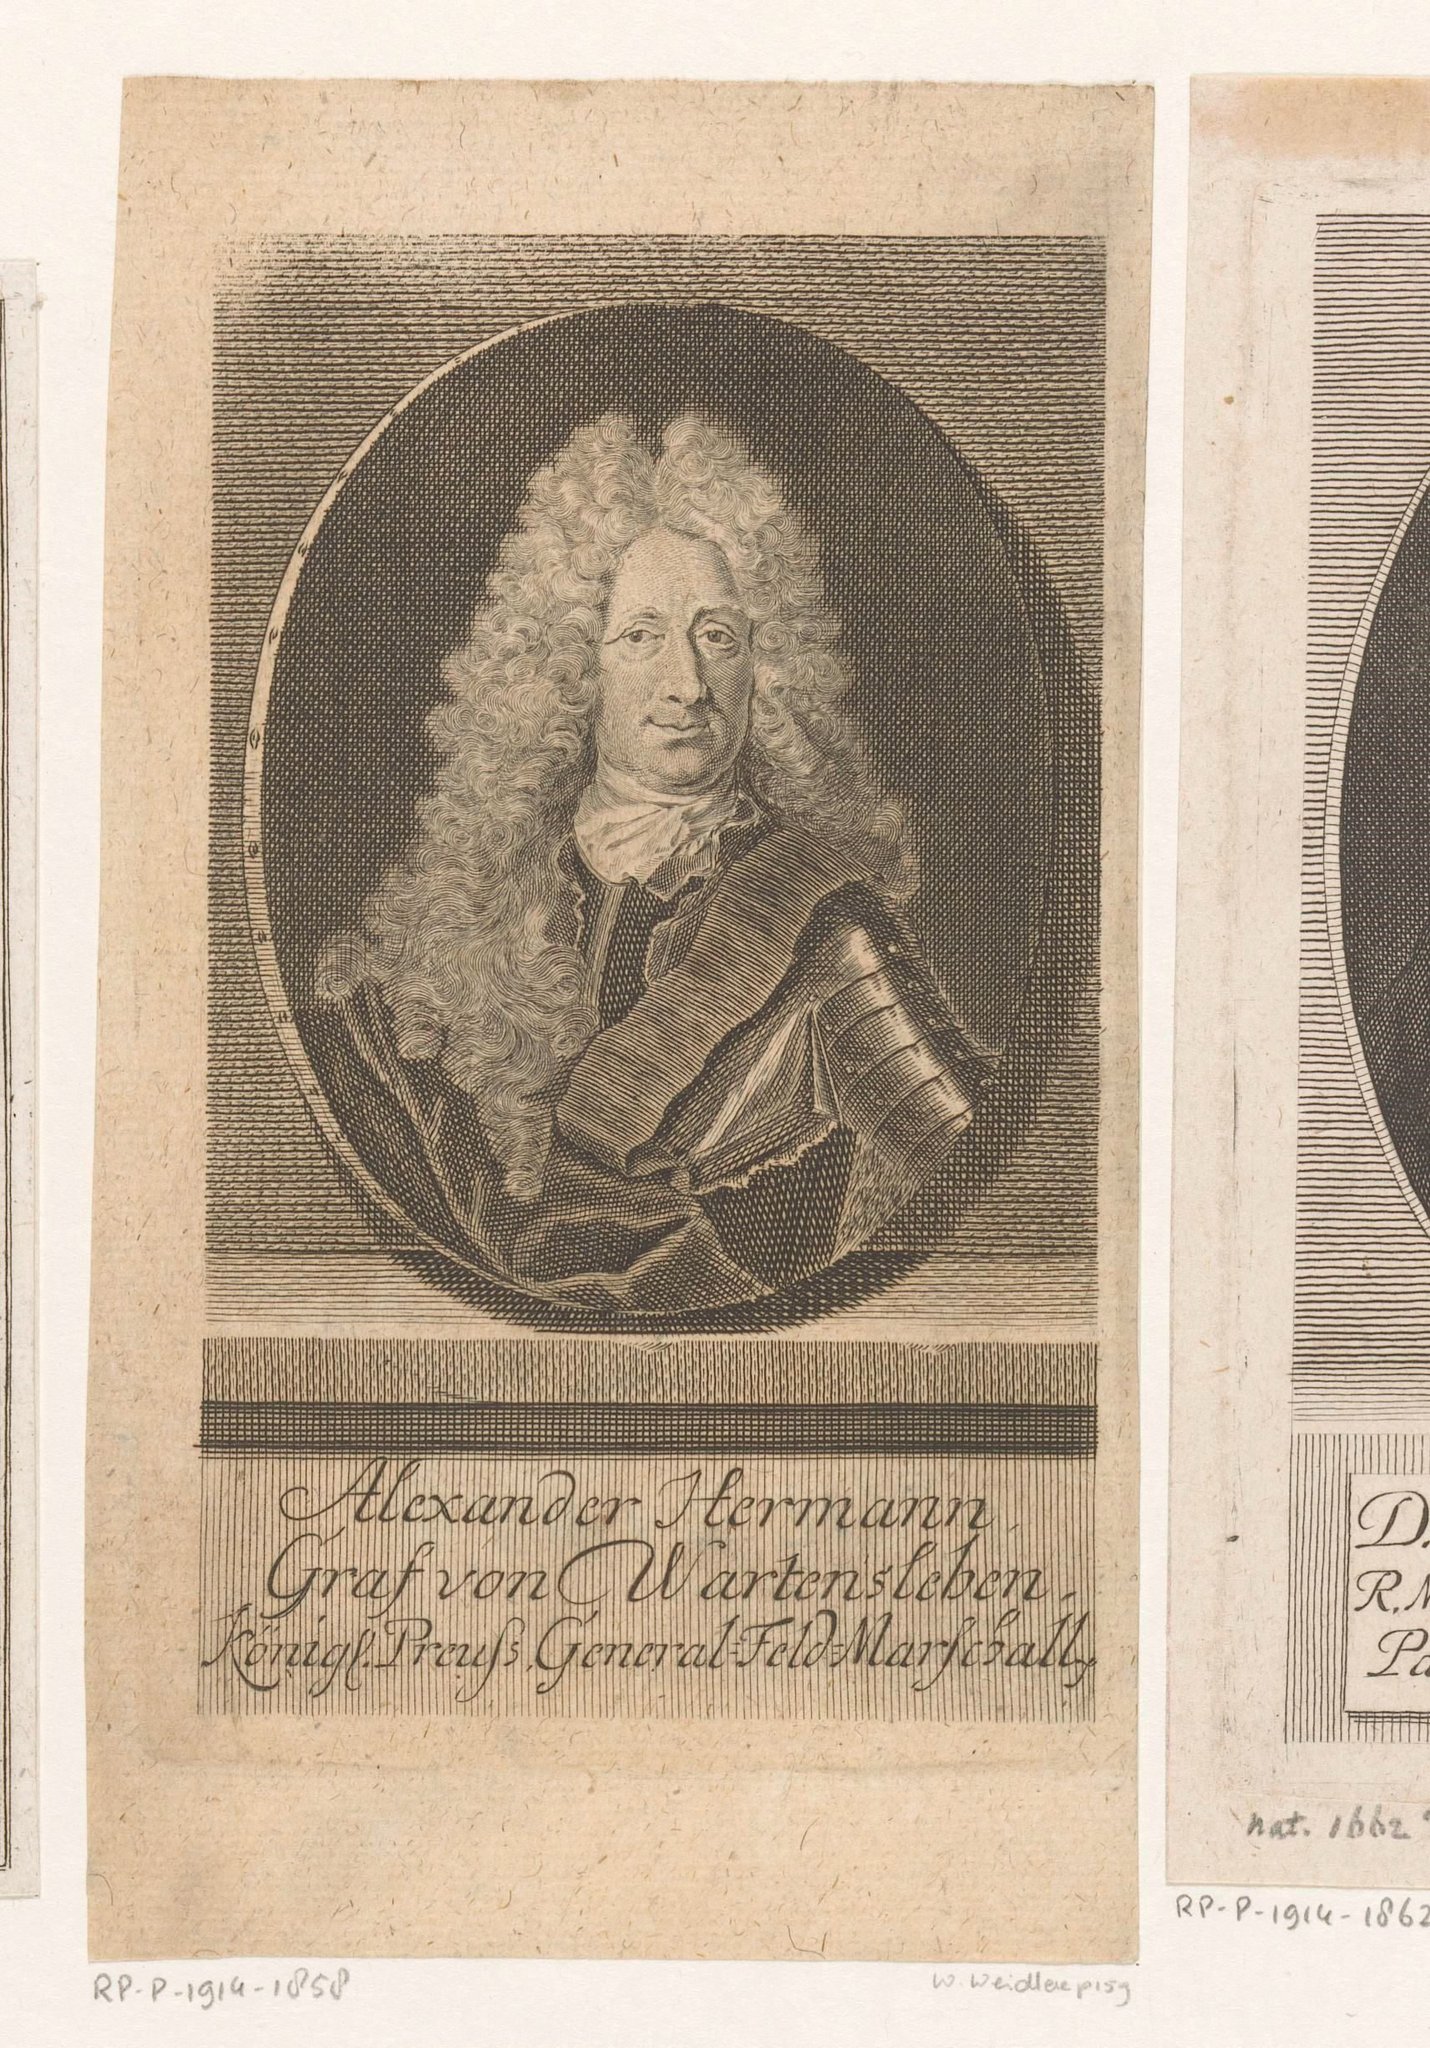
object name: print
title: Portret van Alexander Hermann Graf von Wartensleben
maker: martin bernigeroth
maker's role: print maker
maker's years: 1670-1733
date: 1717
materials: paper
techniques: engraving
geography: leipzig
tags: berlin, earl, armour, historical persons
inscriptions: collector's mark: Lugt 2228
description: Prent ook gebruikt in: Die Europäische Fama, Welche den gegenwärtigen Zustand der vornehmsten Höfe entdecket. dl. 198. Leipzig: Gleditsch, 1717.